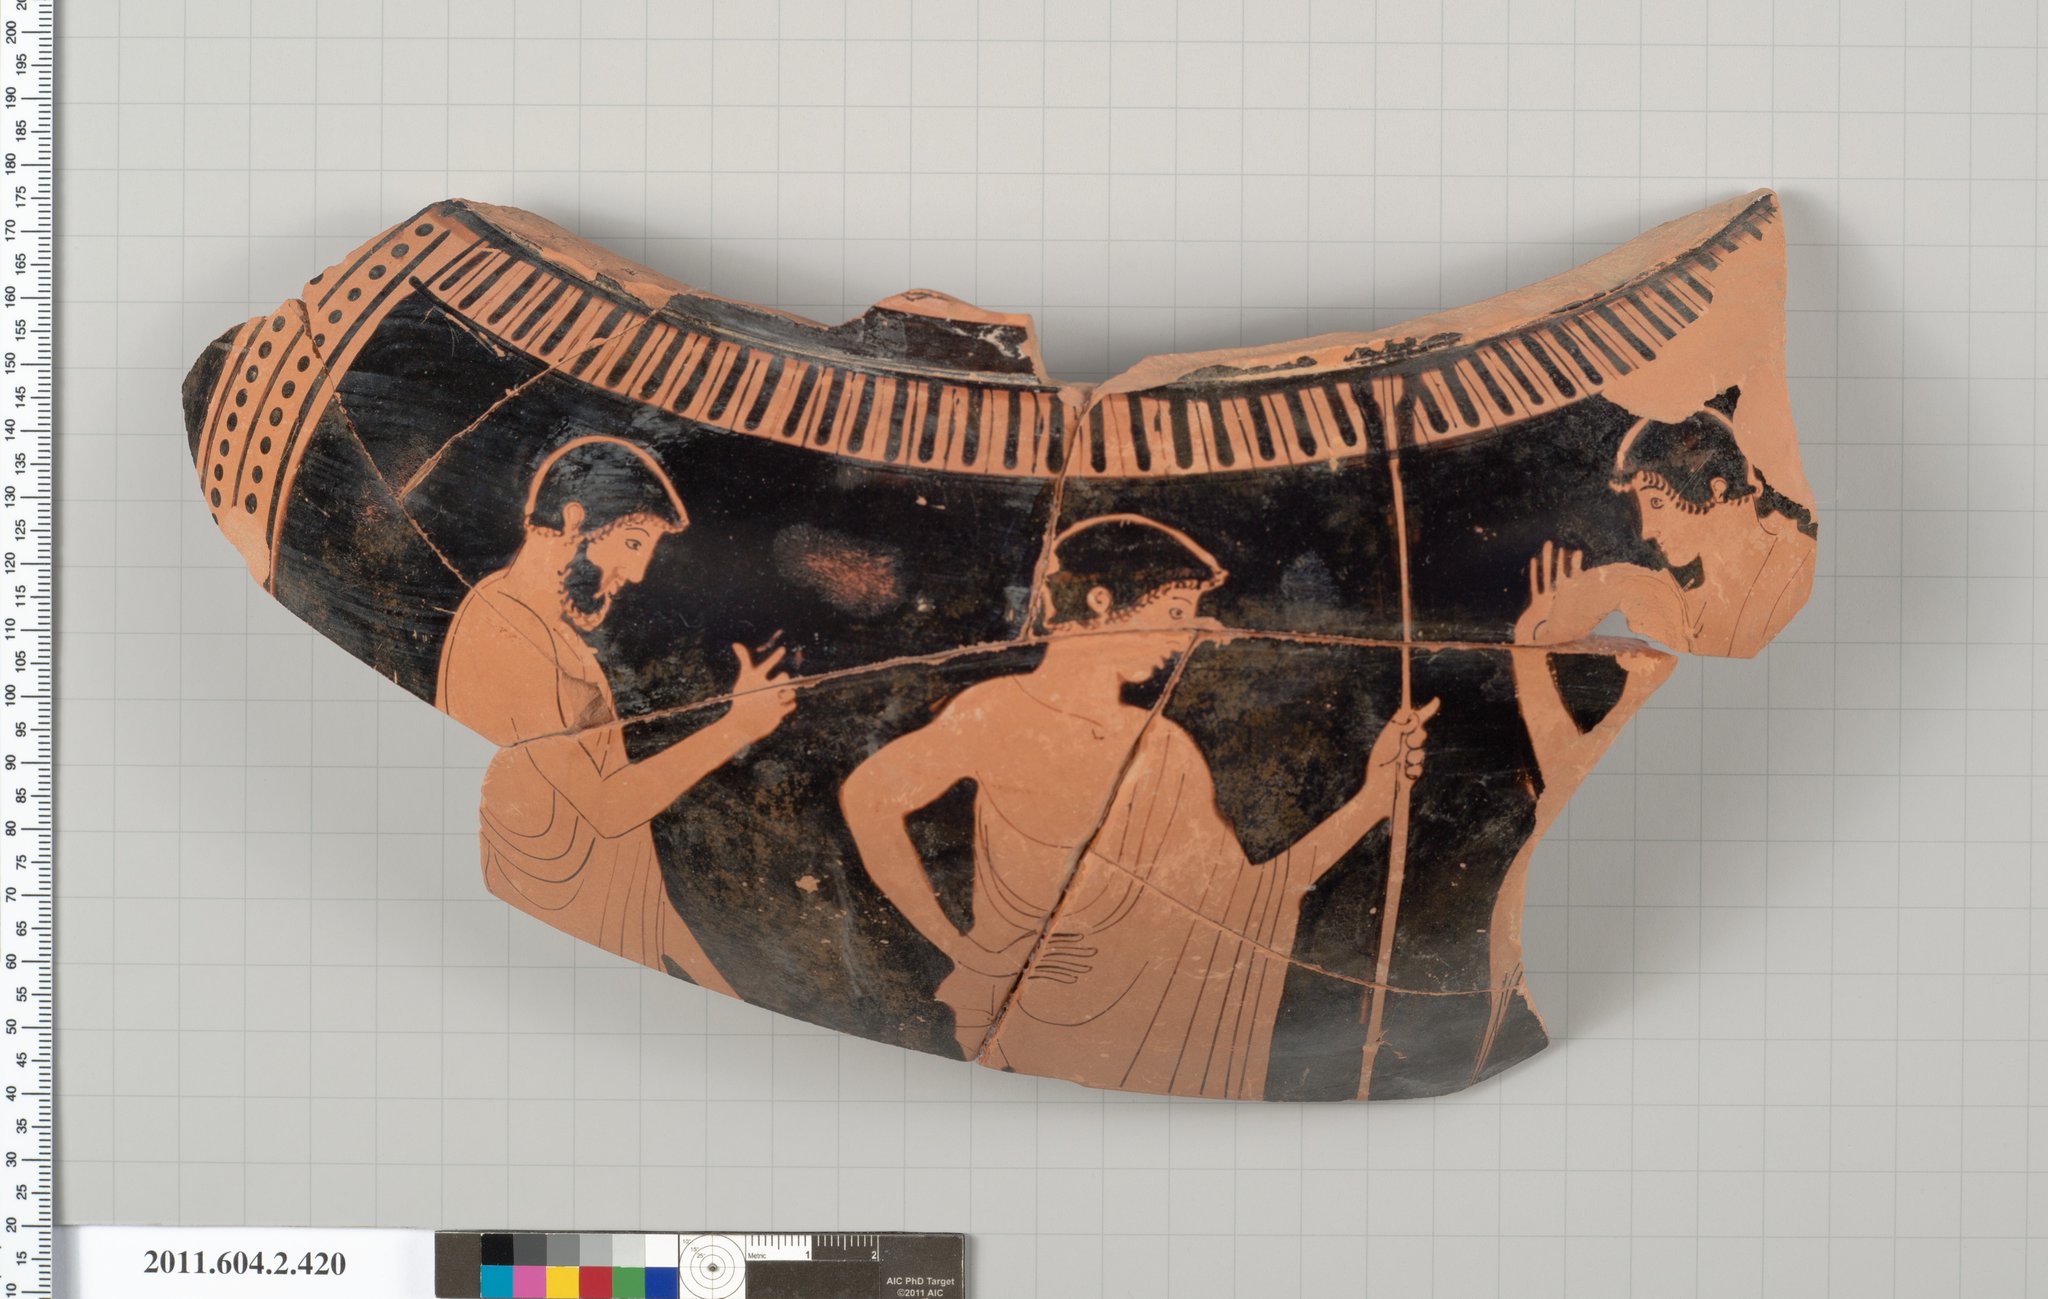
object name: column krater fragment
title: Terracotta fragment of a column-krater (bowl for mixing wine and water)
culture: greek, attic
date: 460-440 BCE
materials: terracotta